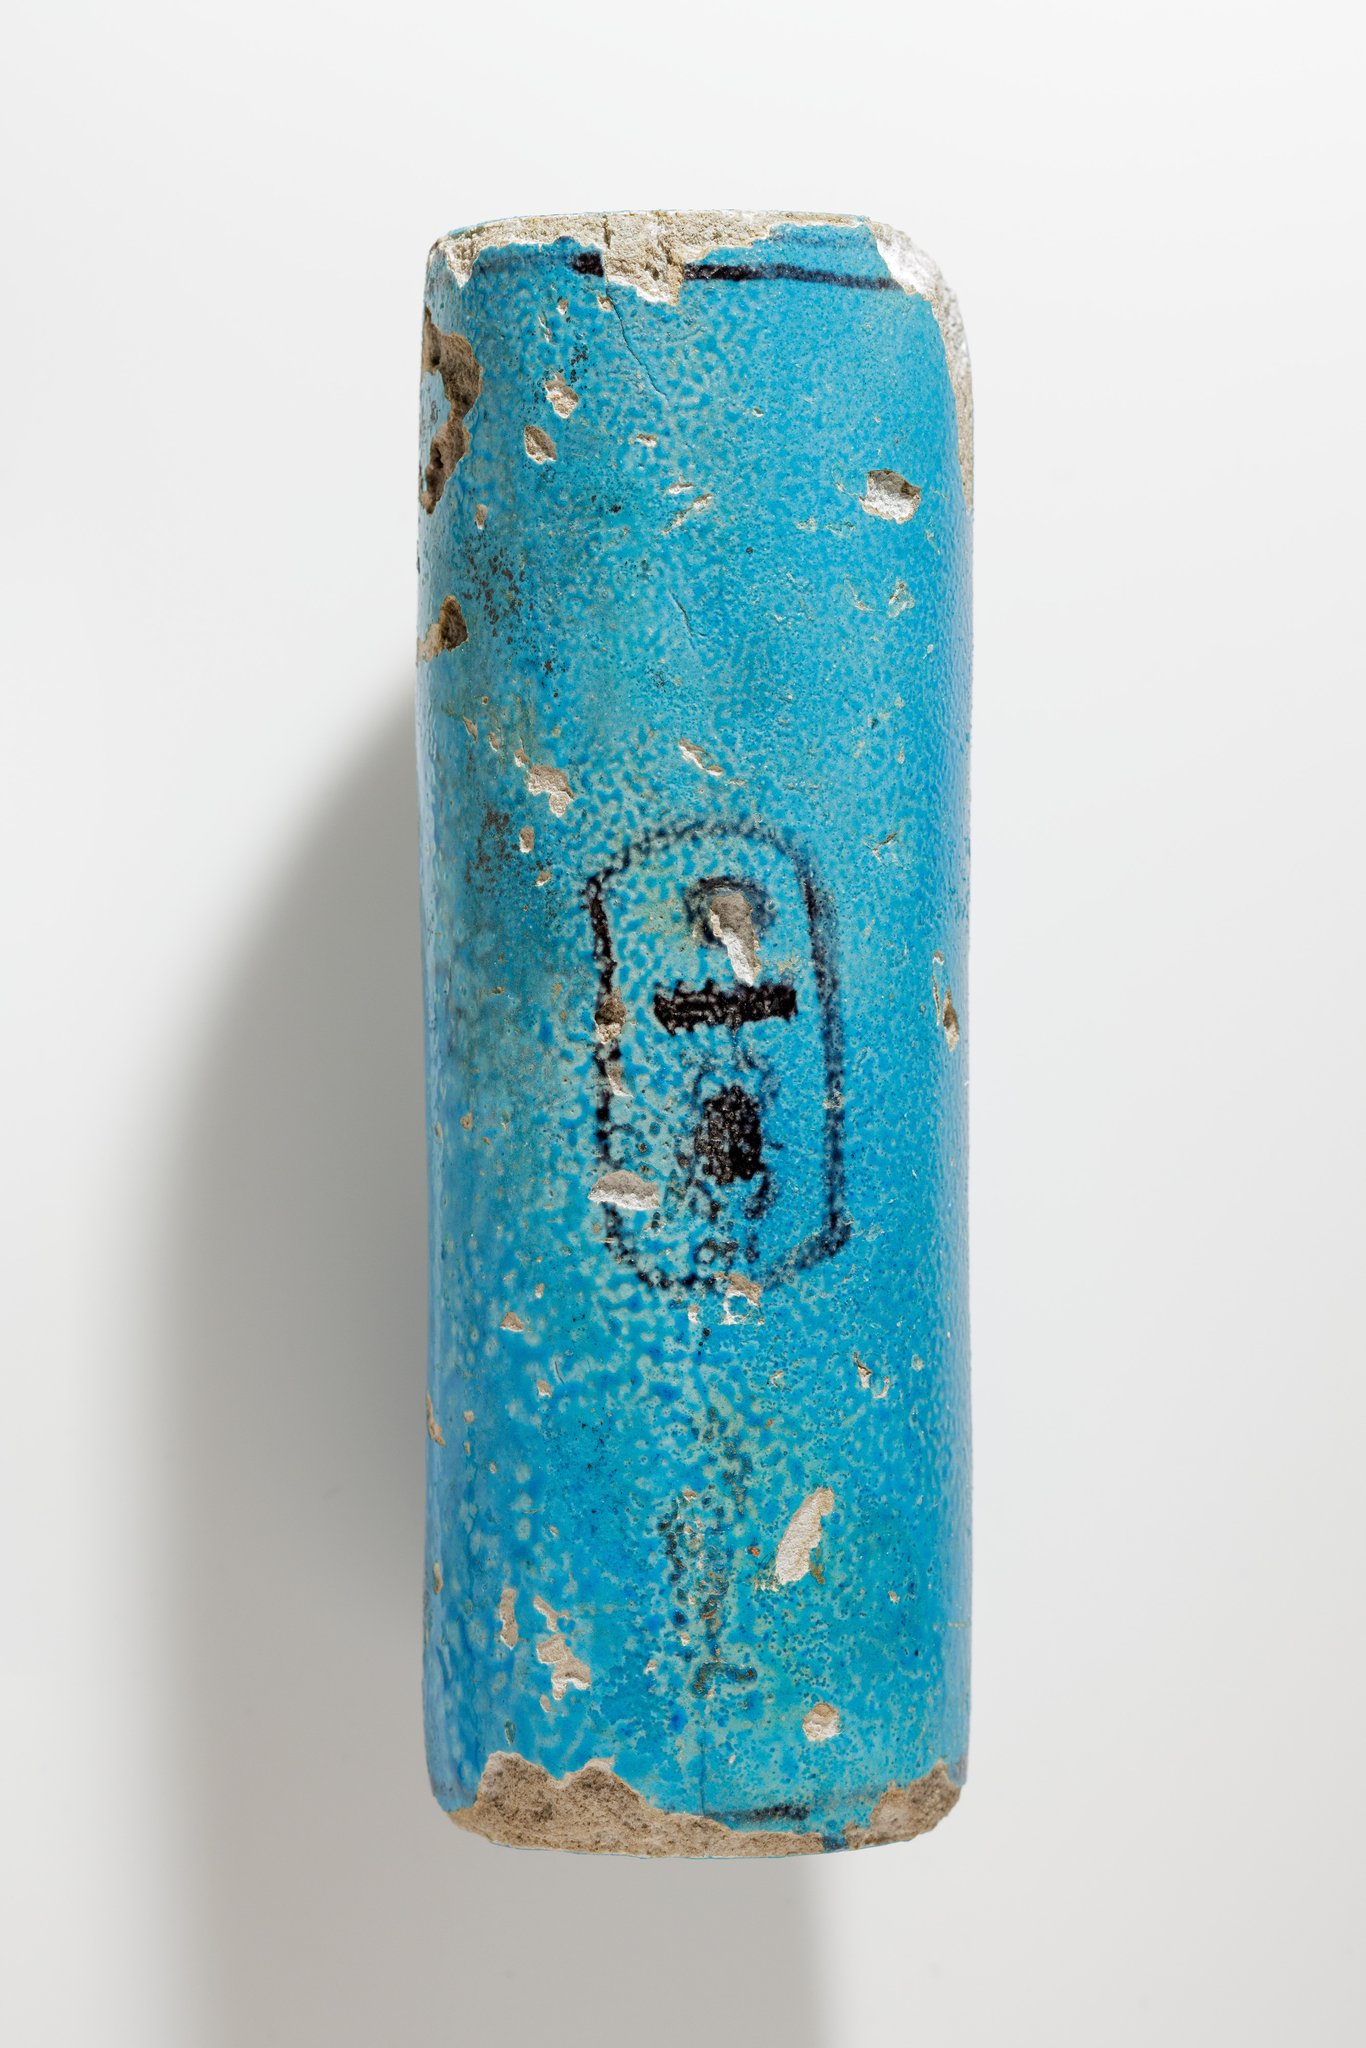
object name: model papyrus roll, thutmose iv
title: Model of Papyrus Roll from the Tomb of Thutmose IV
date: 1400-1390 BCE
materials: faience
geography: egypt